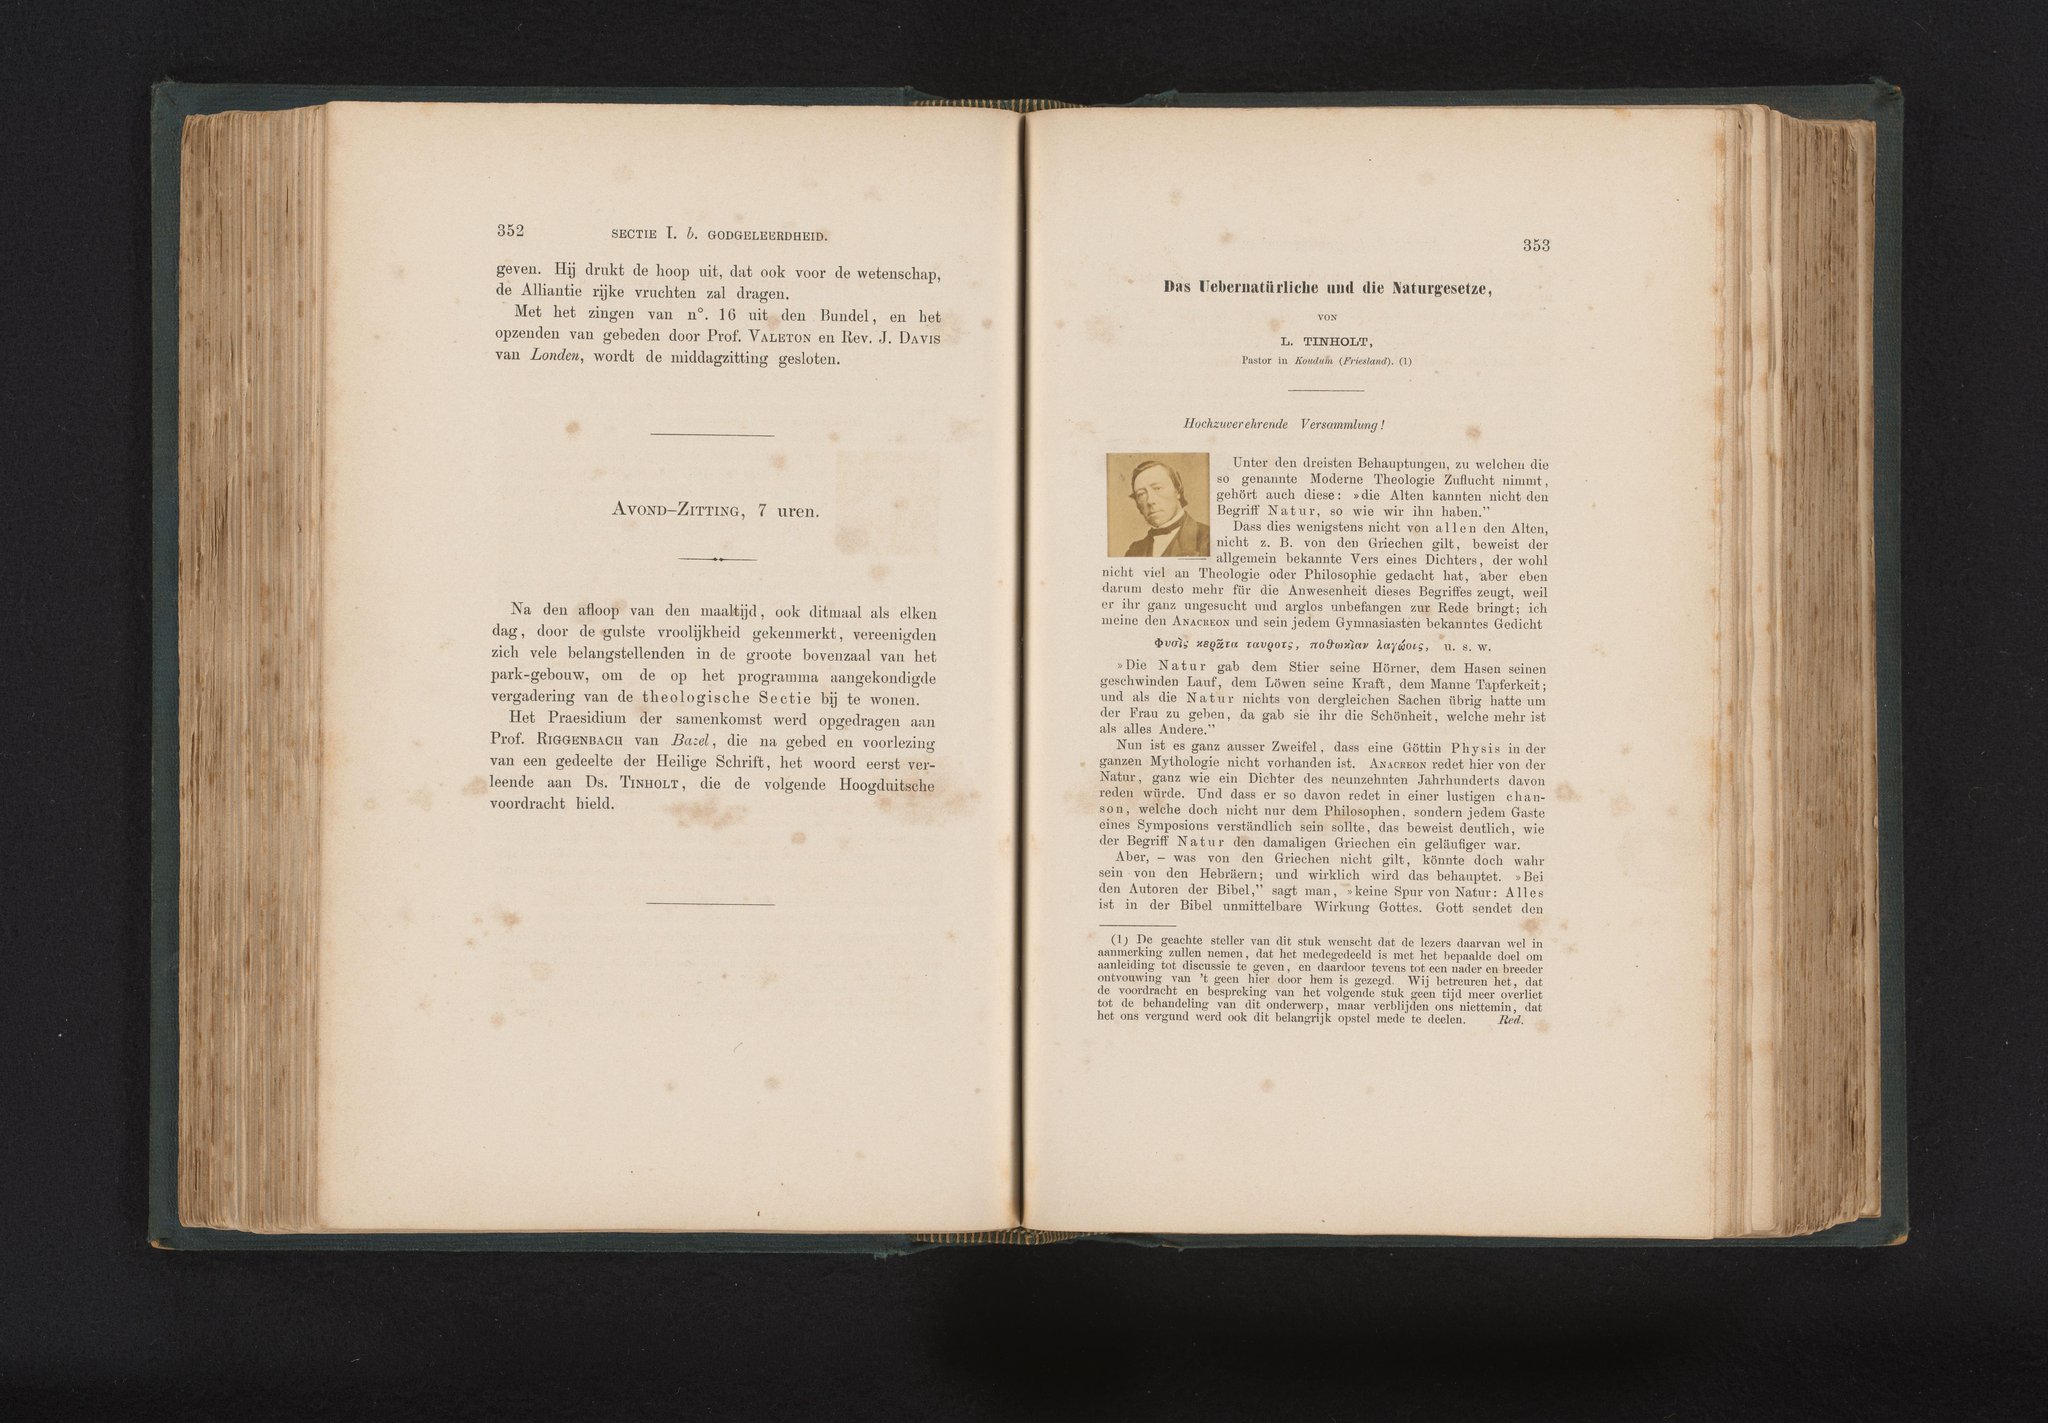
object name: page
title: Portret van Lambert Tinholt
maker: Anonymous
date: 1855-1867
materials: paper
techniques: albumen print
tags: historical persons